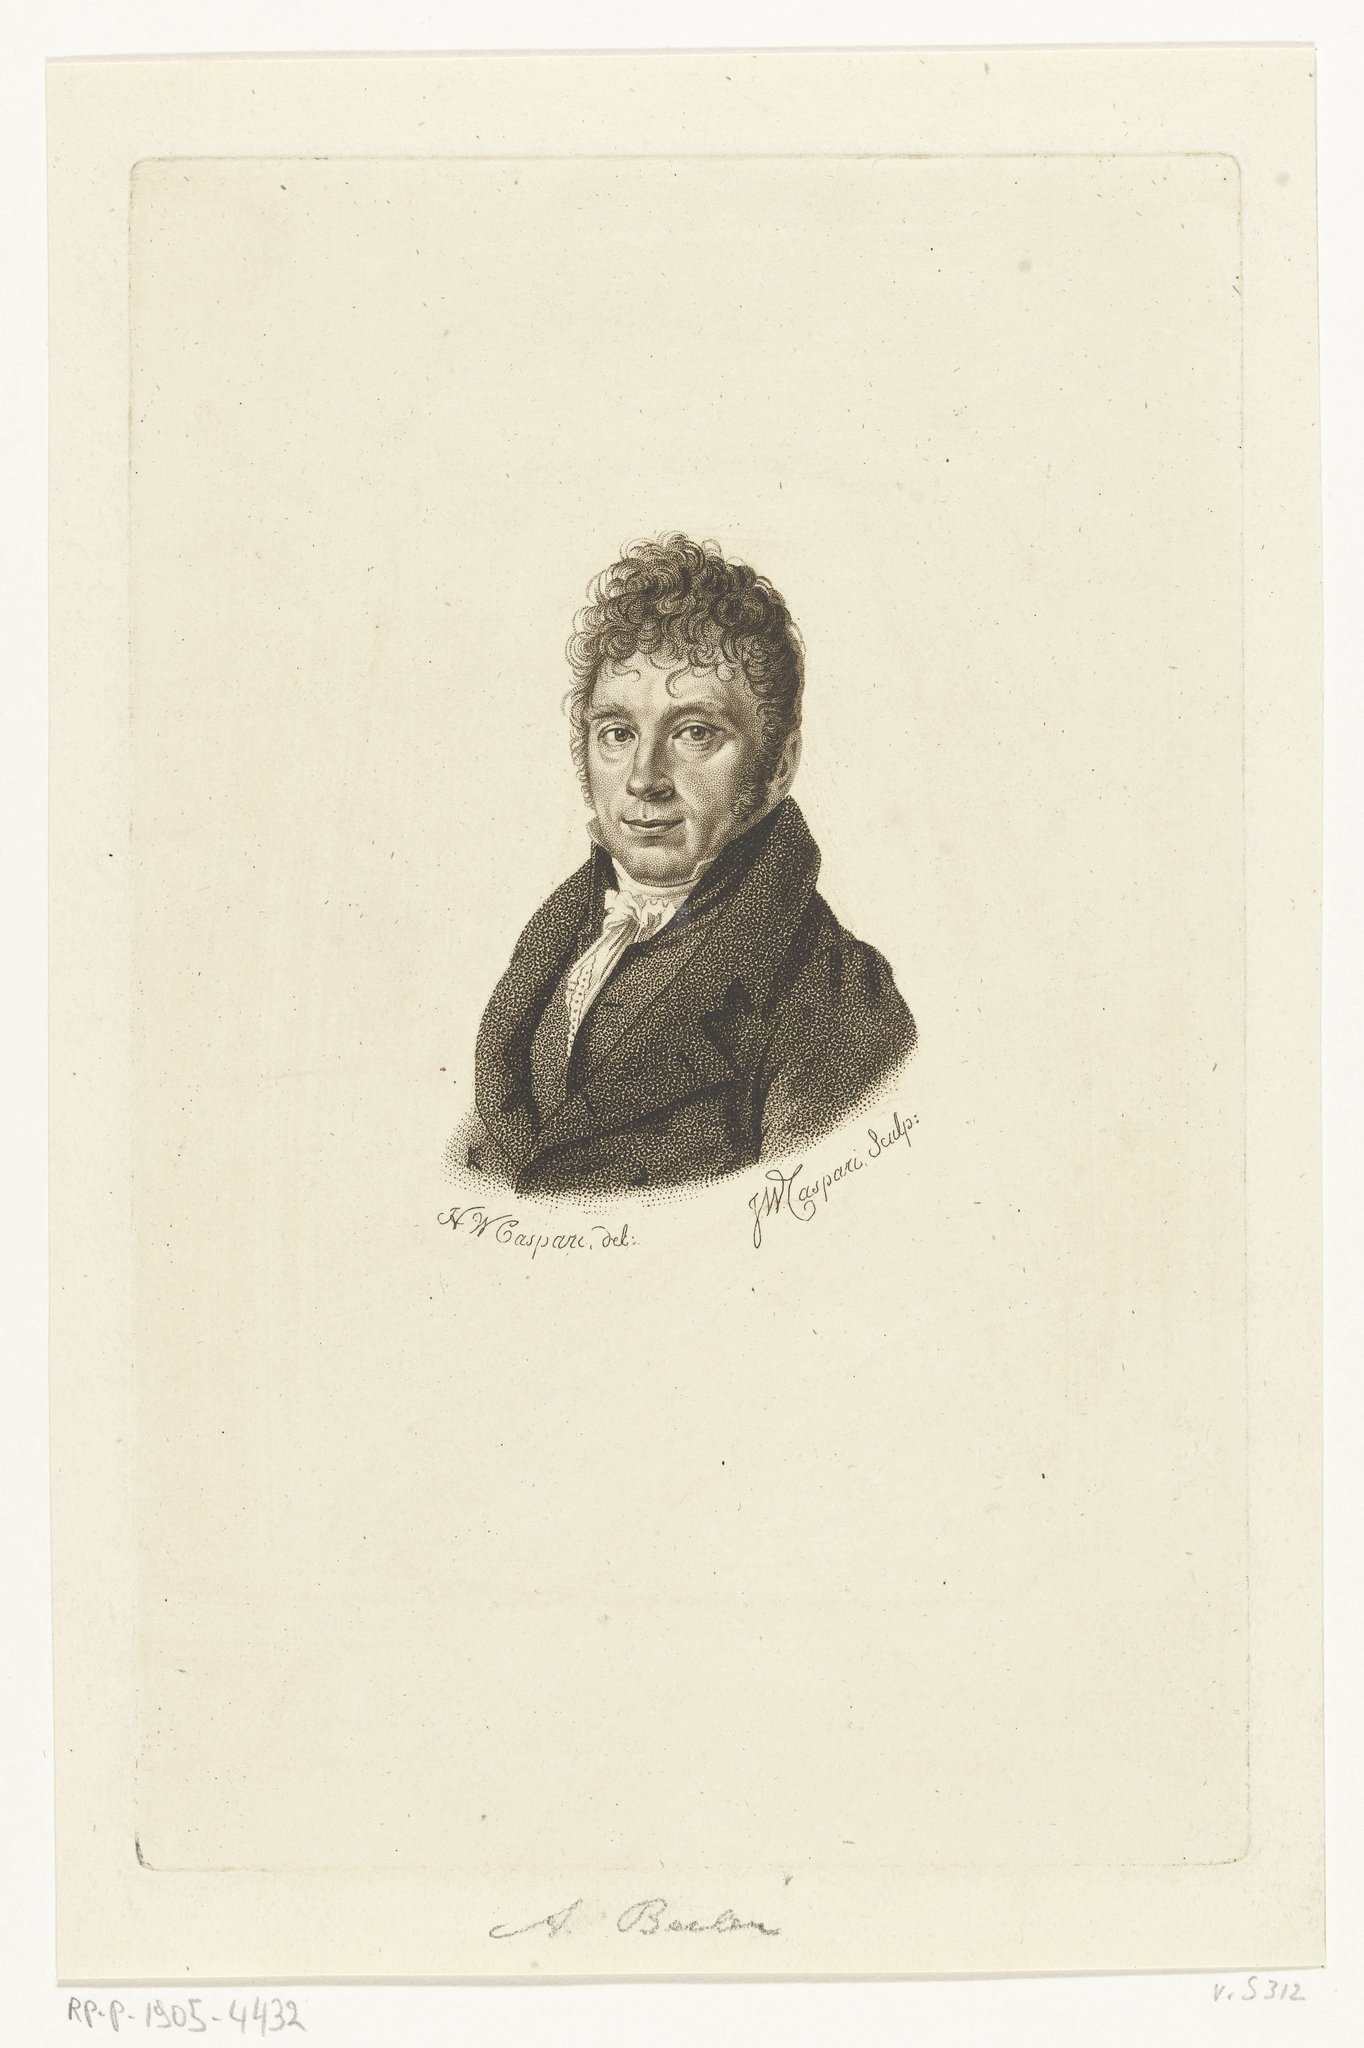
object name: print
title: Portret van A. Beeler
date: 1789-1822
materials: paper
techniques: etching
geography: amsterdam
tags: chemicus, a. beeler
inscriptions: collector's mark: Lugt 2228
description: Portret van A. Beeler, apotheker en chemicus te Amsterdam. Buste naar links. Beeler draagt een zwarte jas.